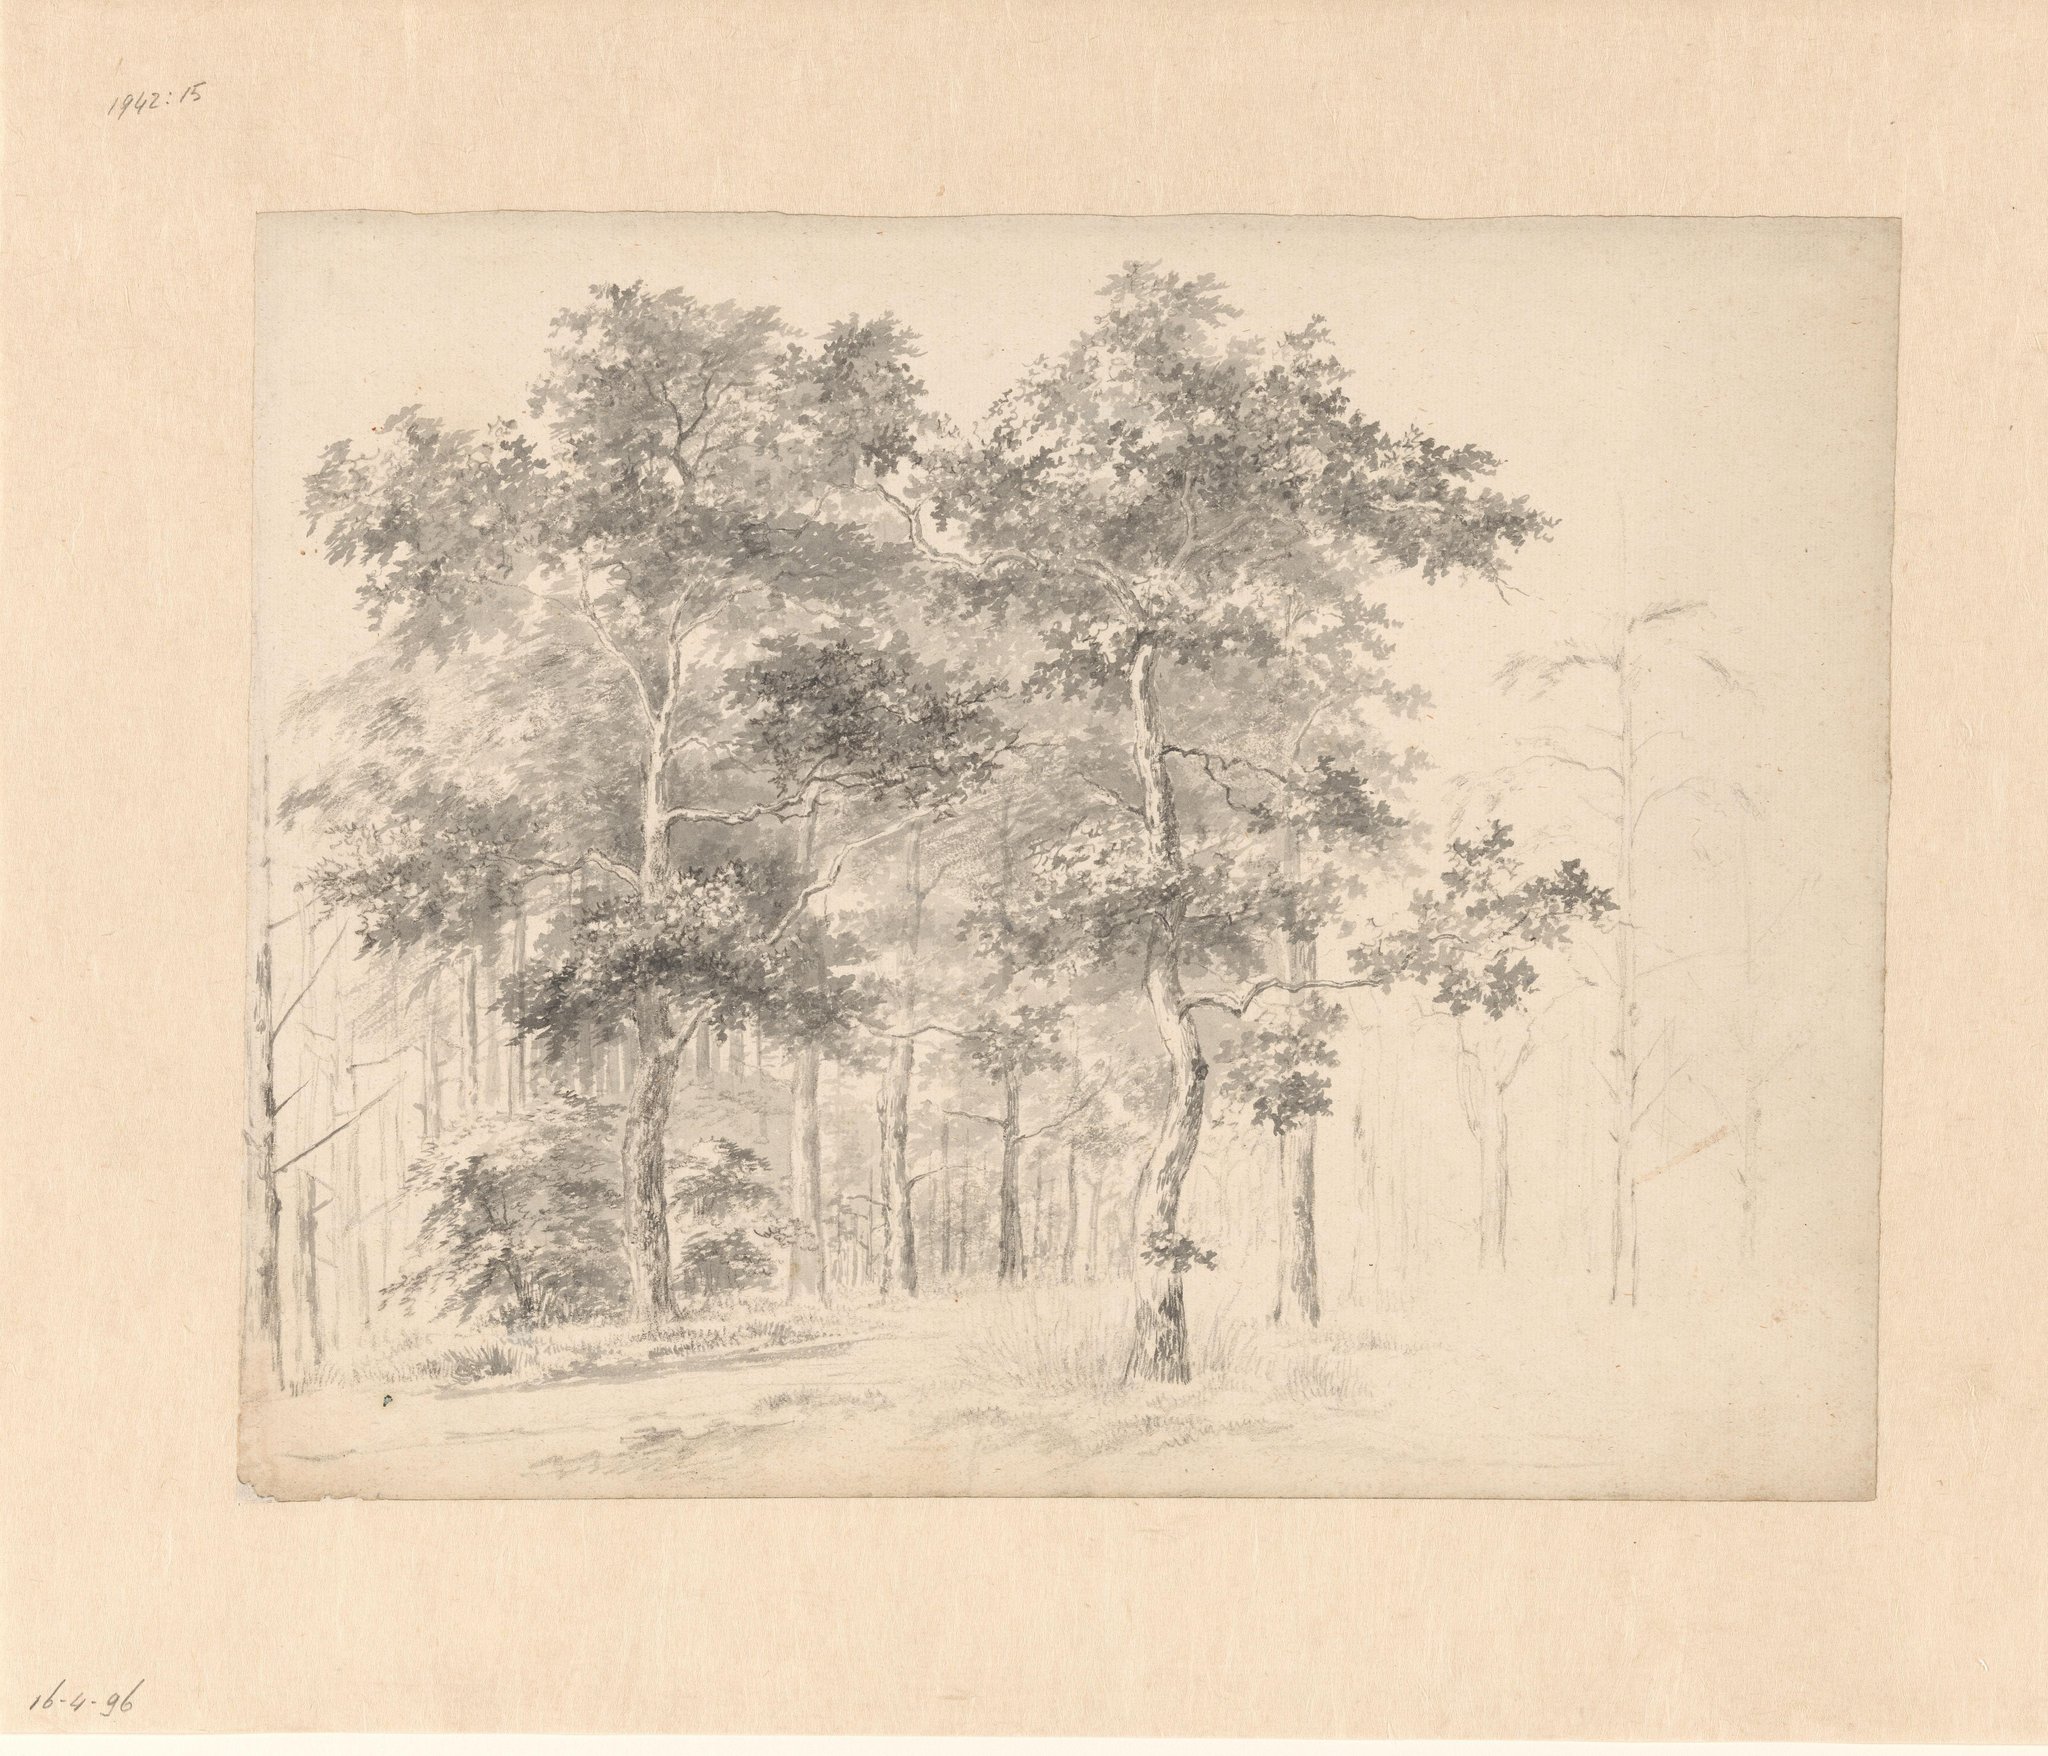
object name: drawing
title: Bosgezicht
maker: Anonymous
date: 1800-1900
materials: chalk, paper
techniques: brush